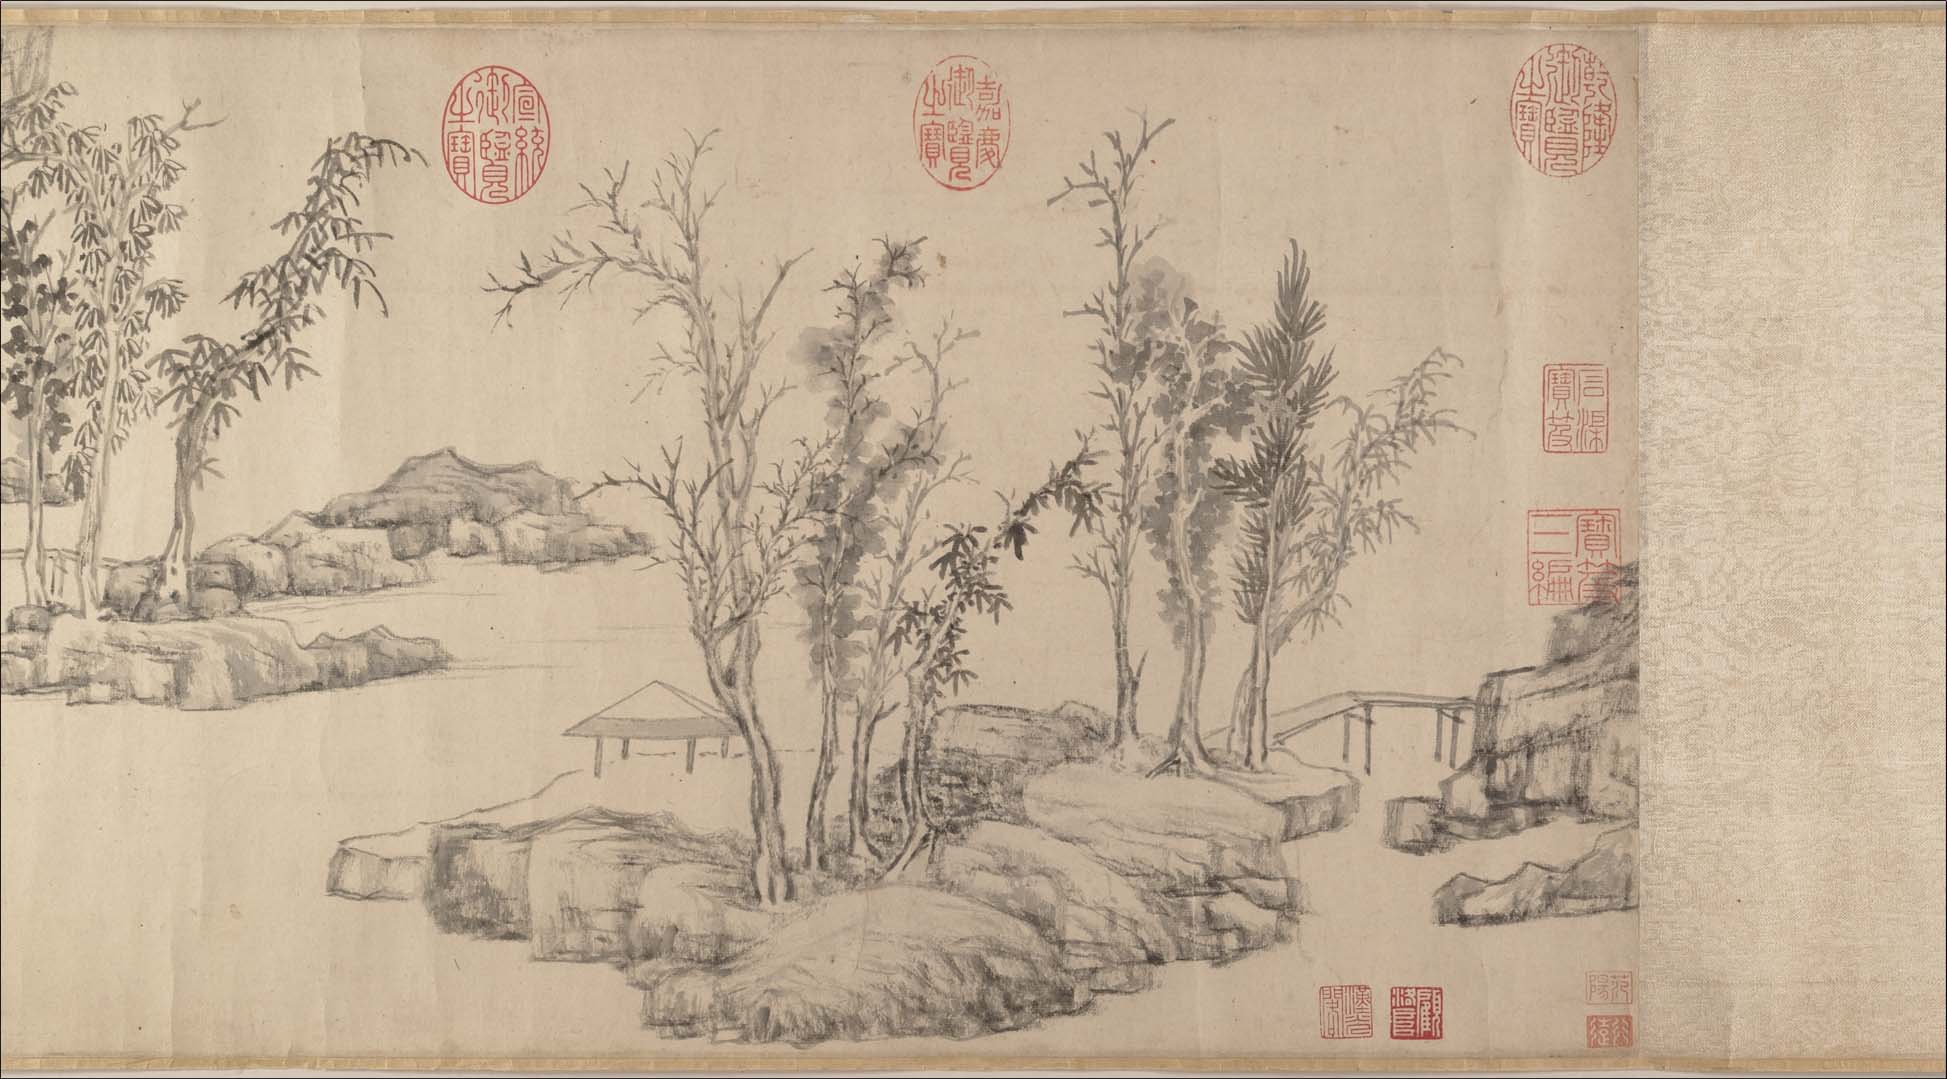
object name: handscroll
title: Summer retreat in the eastern grove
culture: chinese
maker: wen zhengming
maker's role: artist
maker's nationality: chinese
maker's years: 1470-1559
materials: ink, paper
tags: landscapes